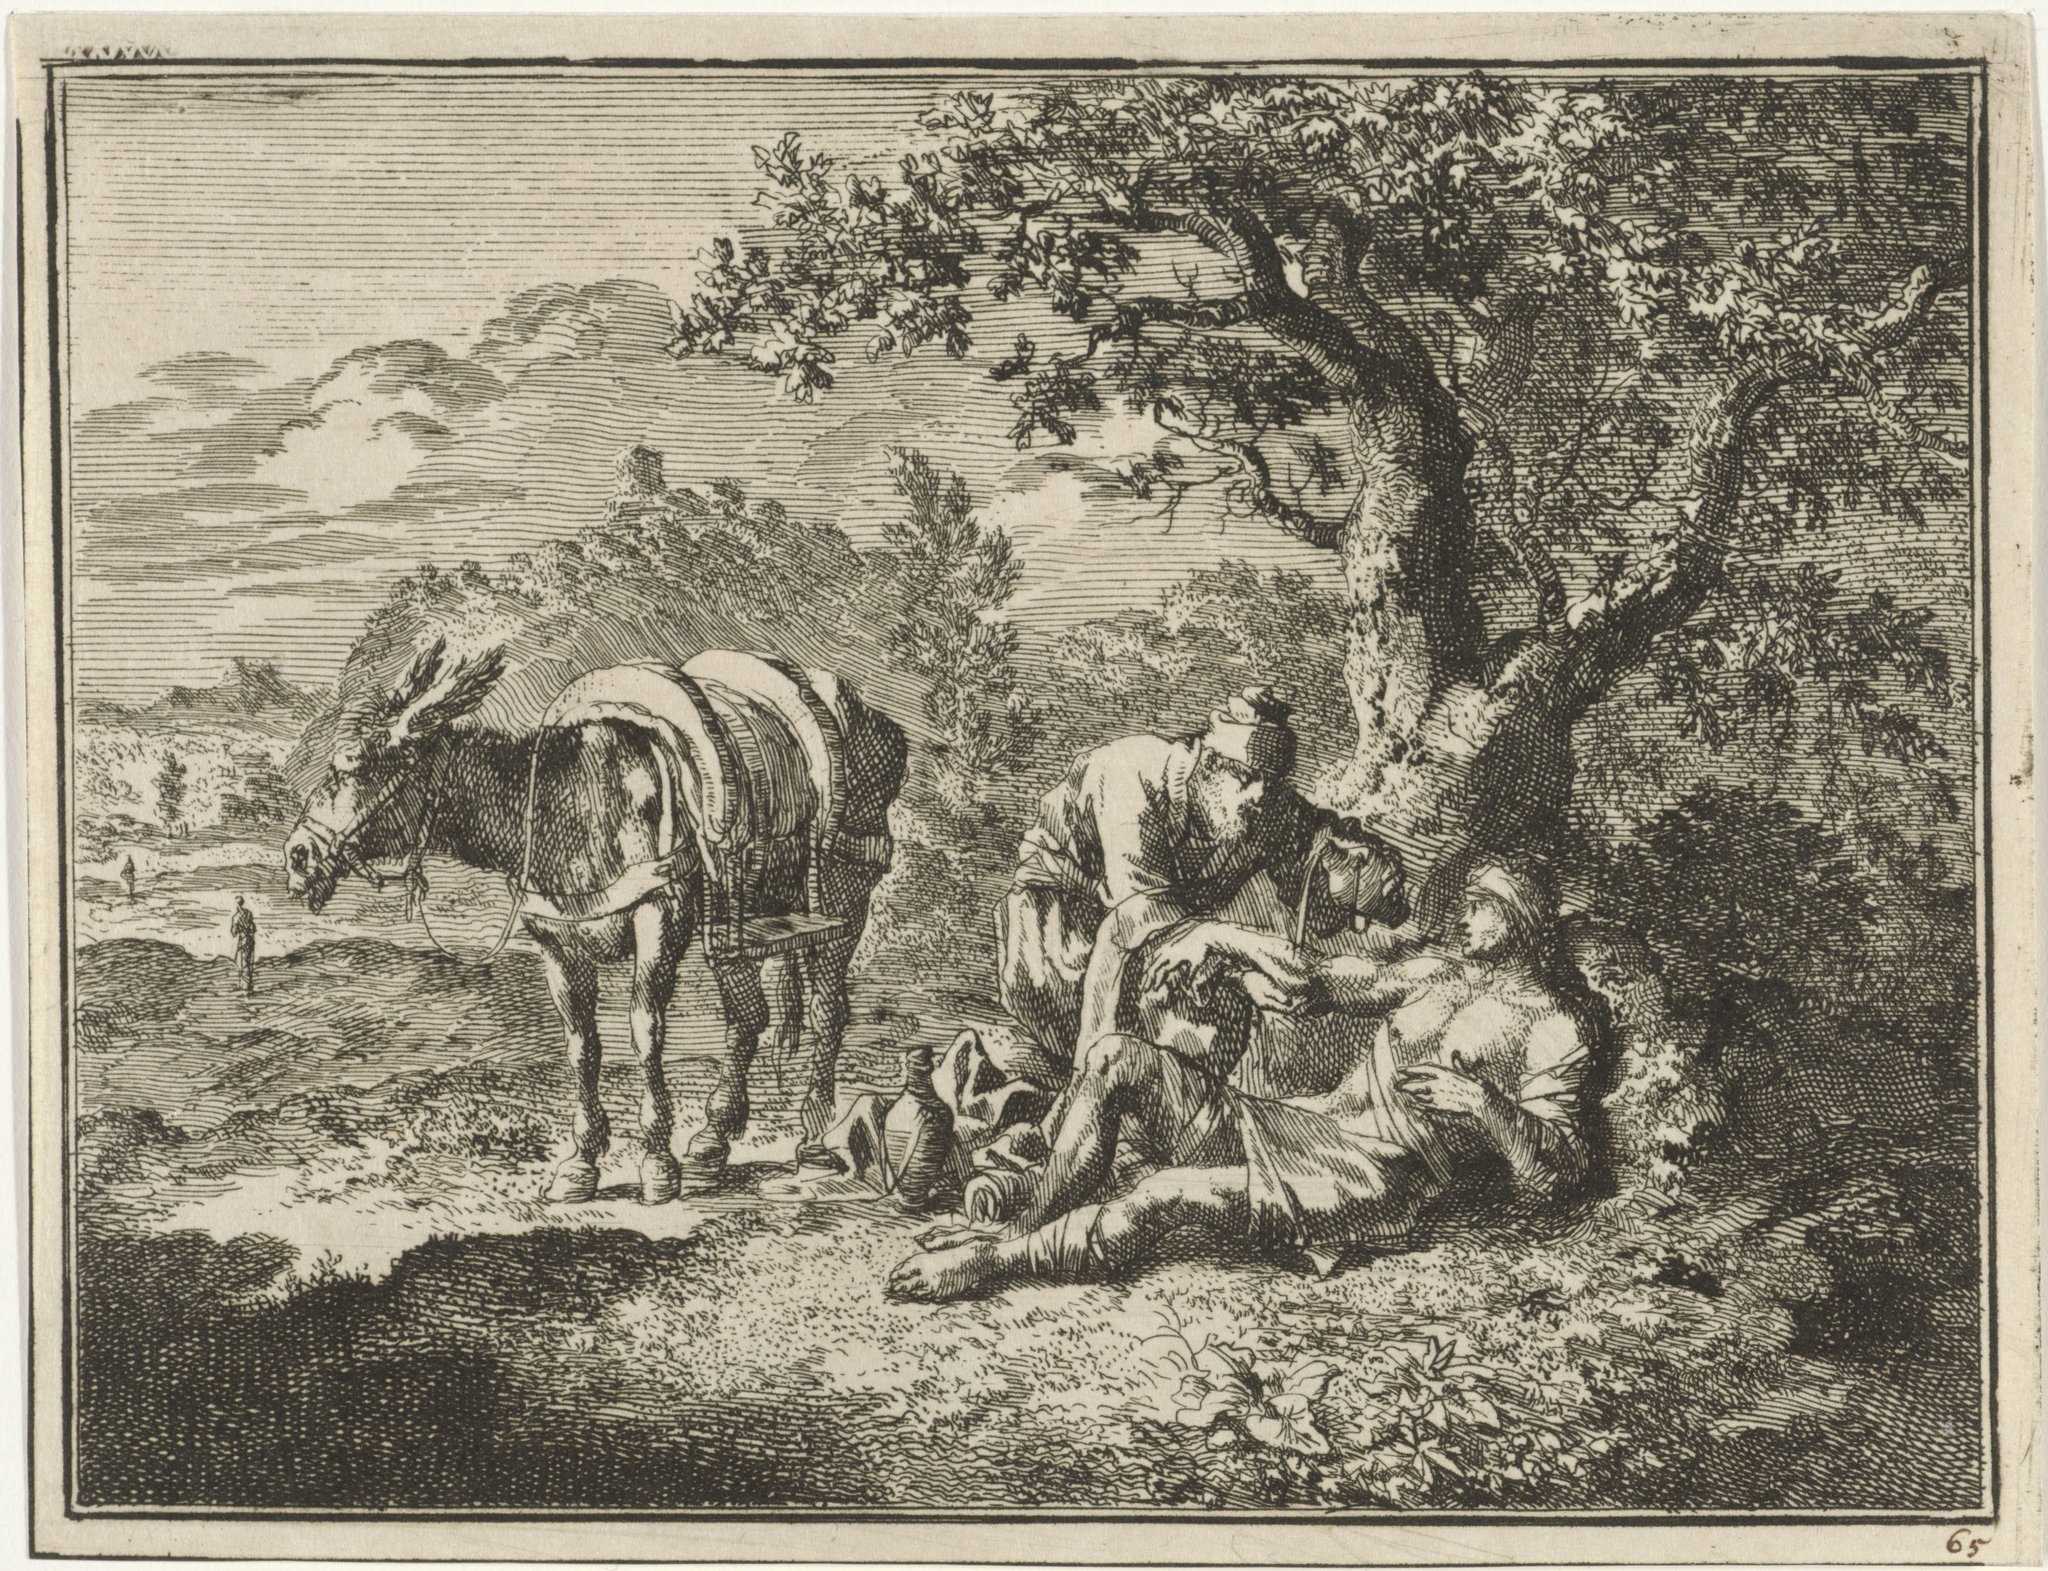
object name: print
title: Barmhartige Samaritaan ontfermt zich over de gewonde reiziger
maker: jan luyken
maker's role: draughtsman, print maker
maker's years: 1649-1712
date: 1712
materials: paper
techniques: etching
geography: amsterdam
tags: the good samaritan (luke 10:30-37)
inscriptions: number: ‘65’, collector's mark: Lugt 2228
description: Proefdruk van illustratie uit: Luyken, Jan. De schriftuurlyke geschiedenissen en gelykenissen van het Oude en Nieuwe Verbond, 2 delen. Amsterdam: Wed. Pieter Arentsz II en Cornelis van der Sys, 1712, dl. II.